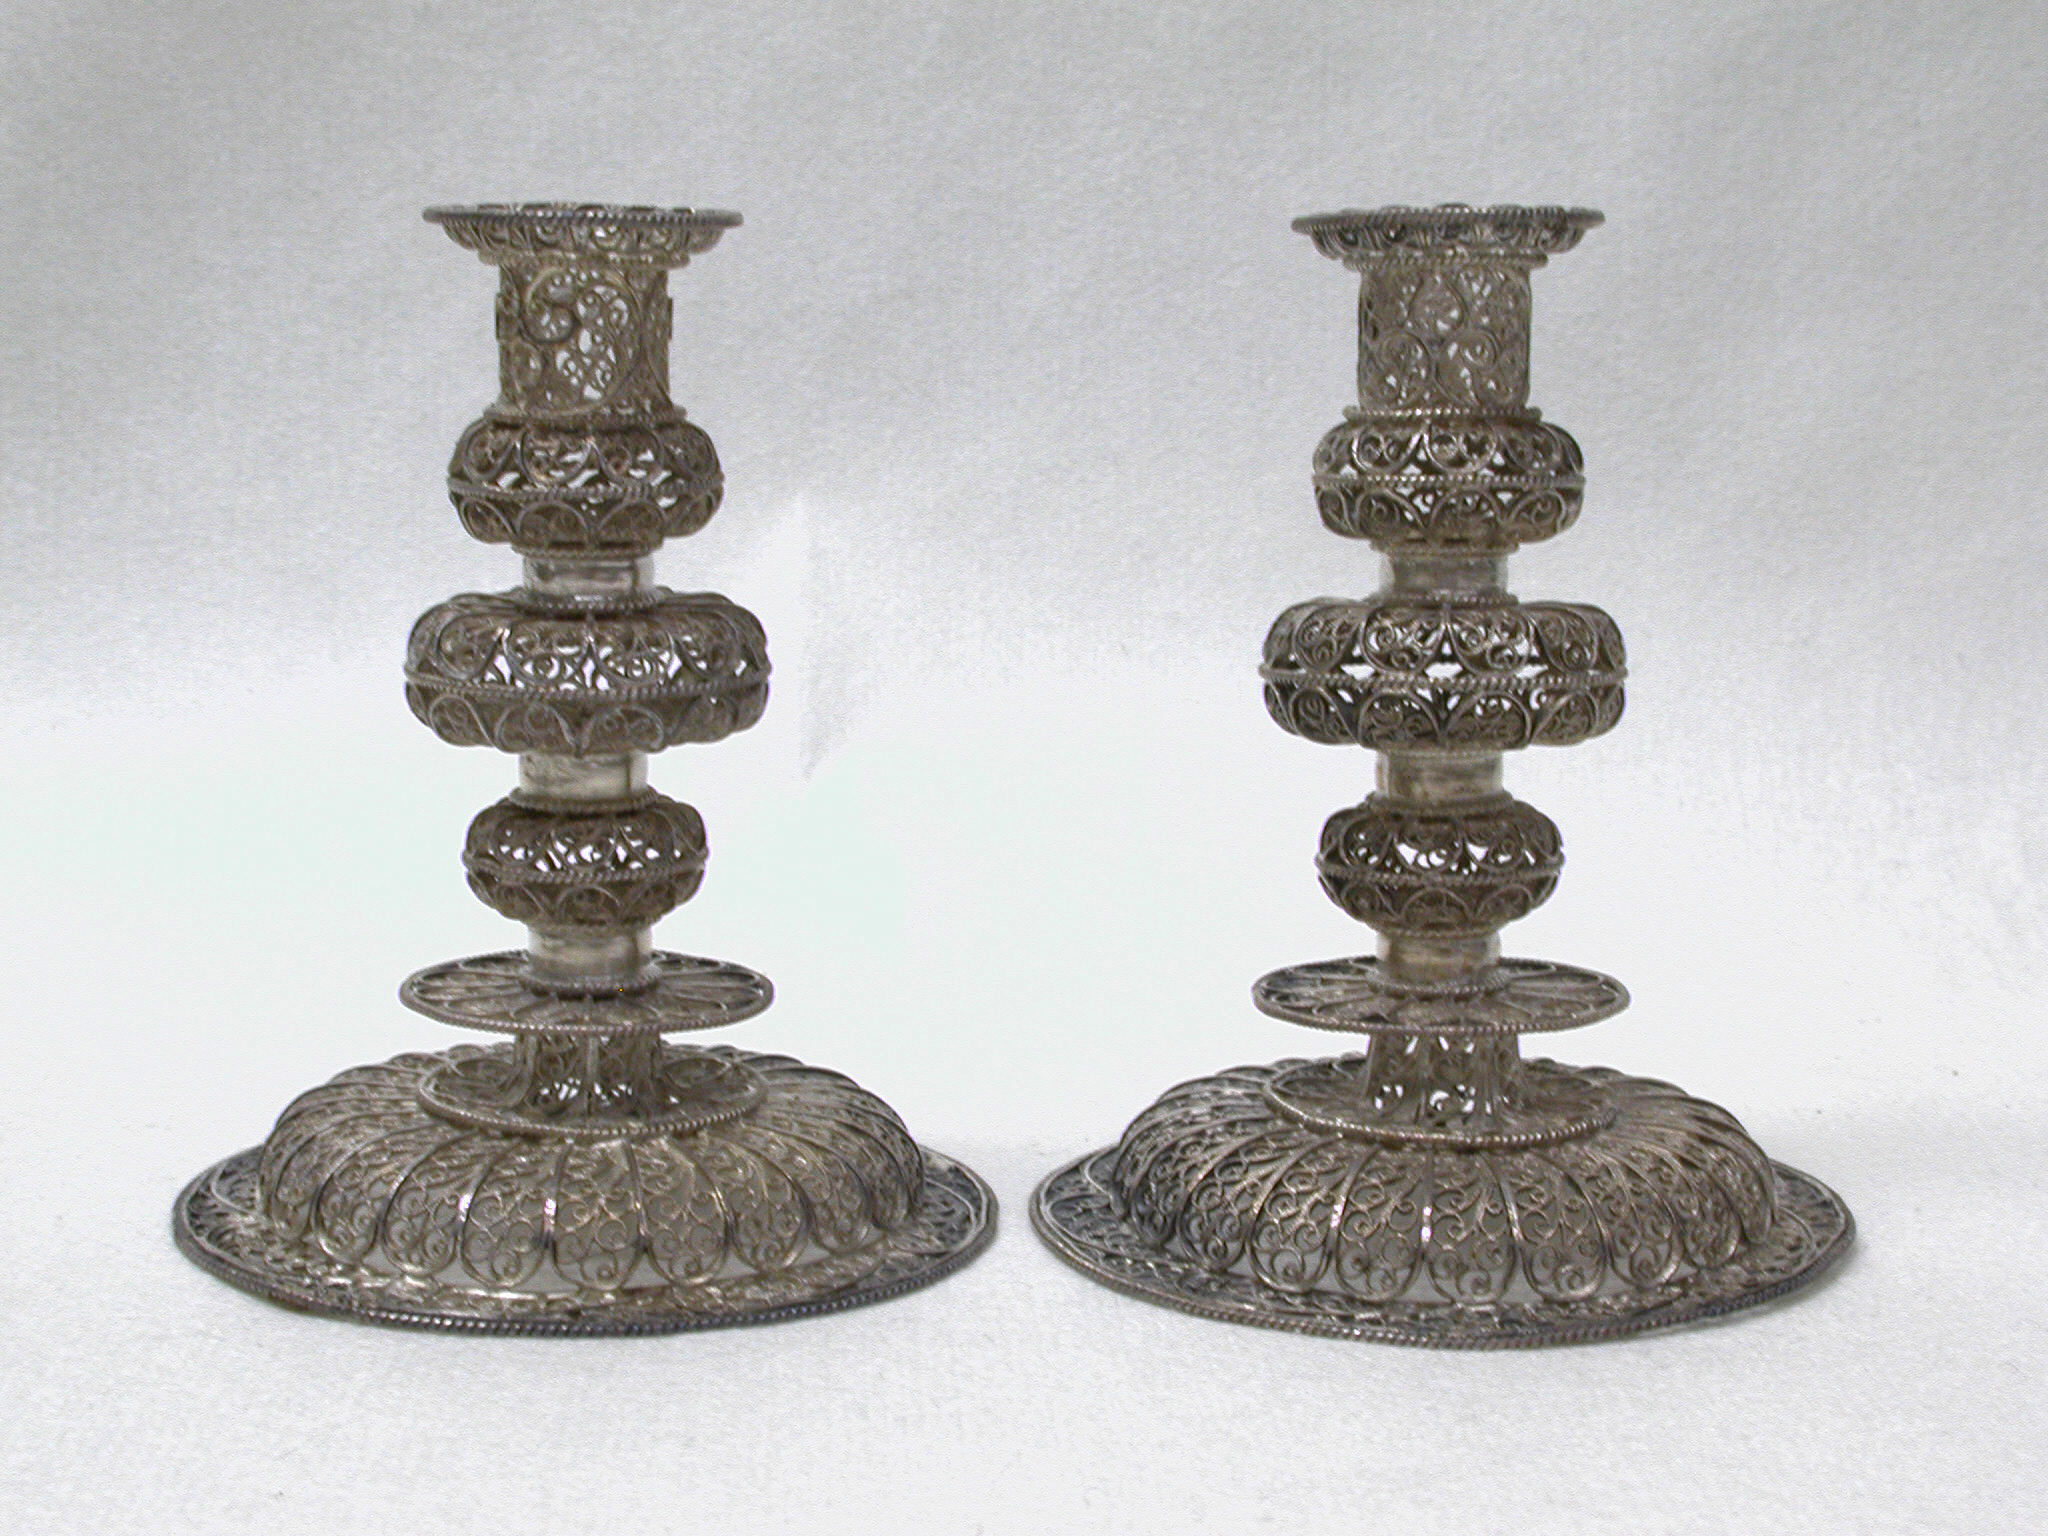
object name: candlestick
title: Miniature candlestick (one of a pair) (part of a set)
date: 1675-1700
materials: silver